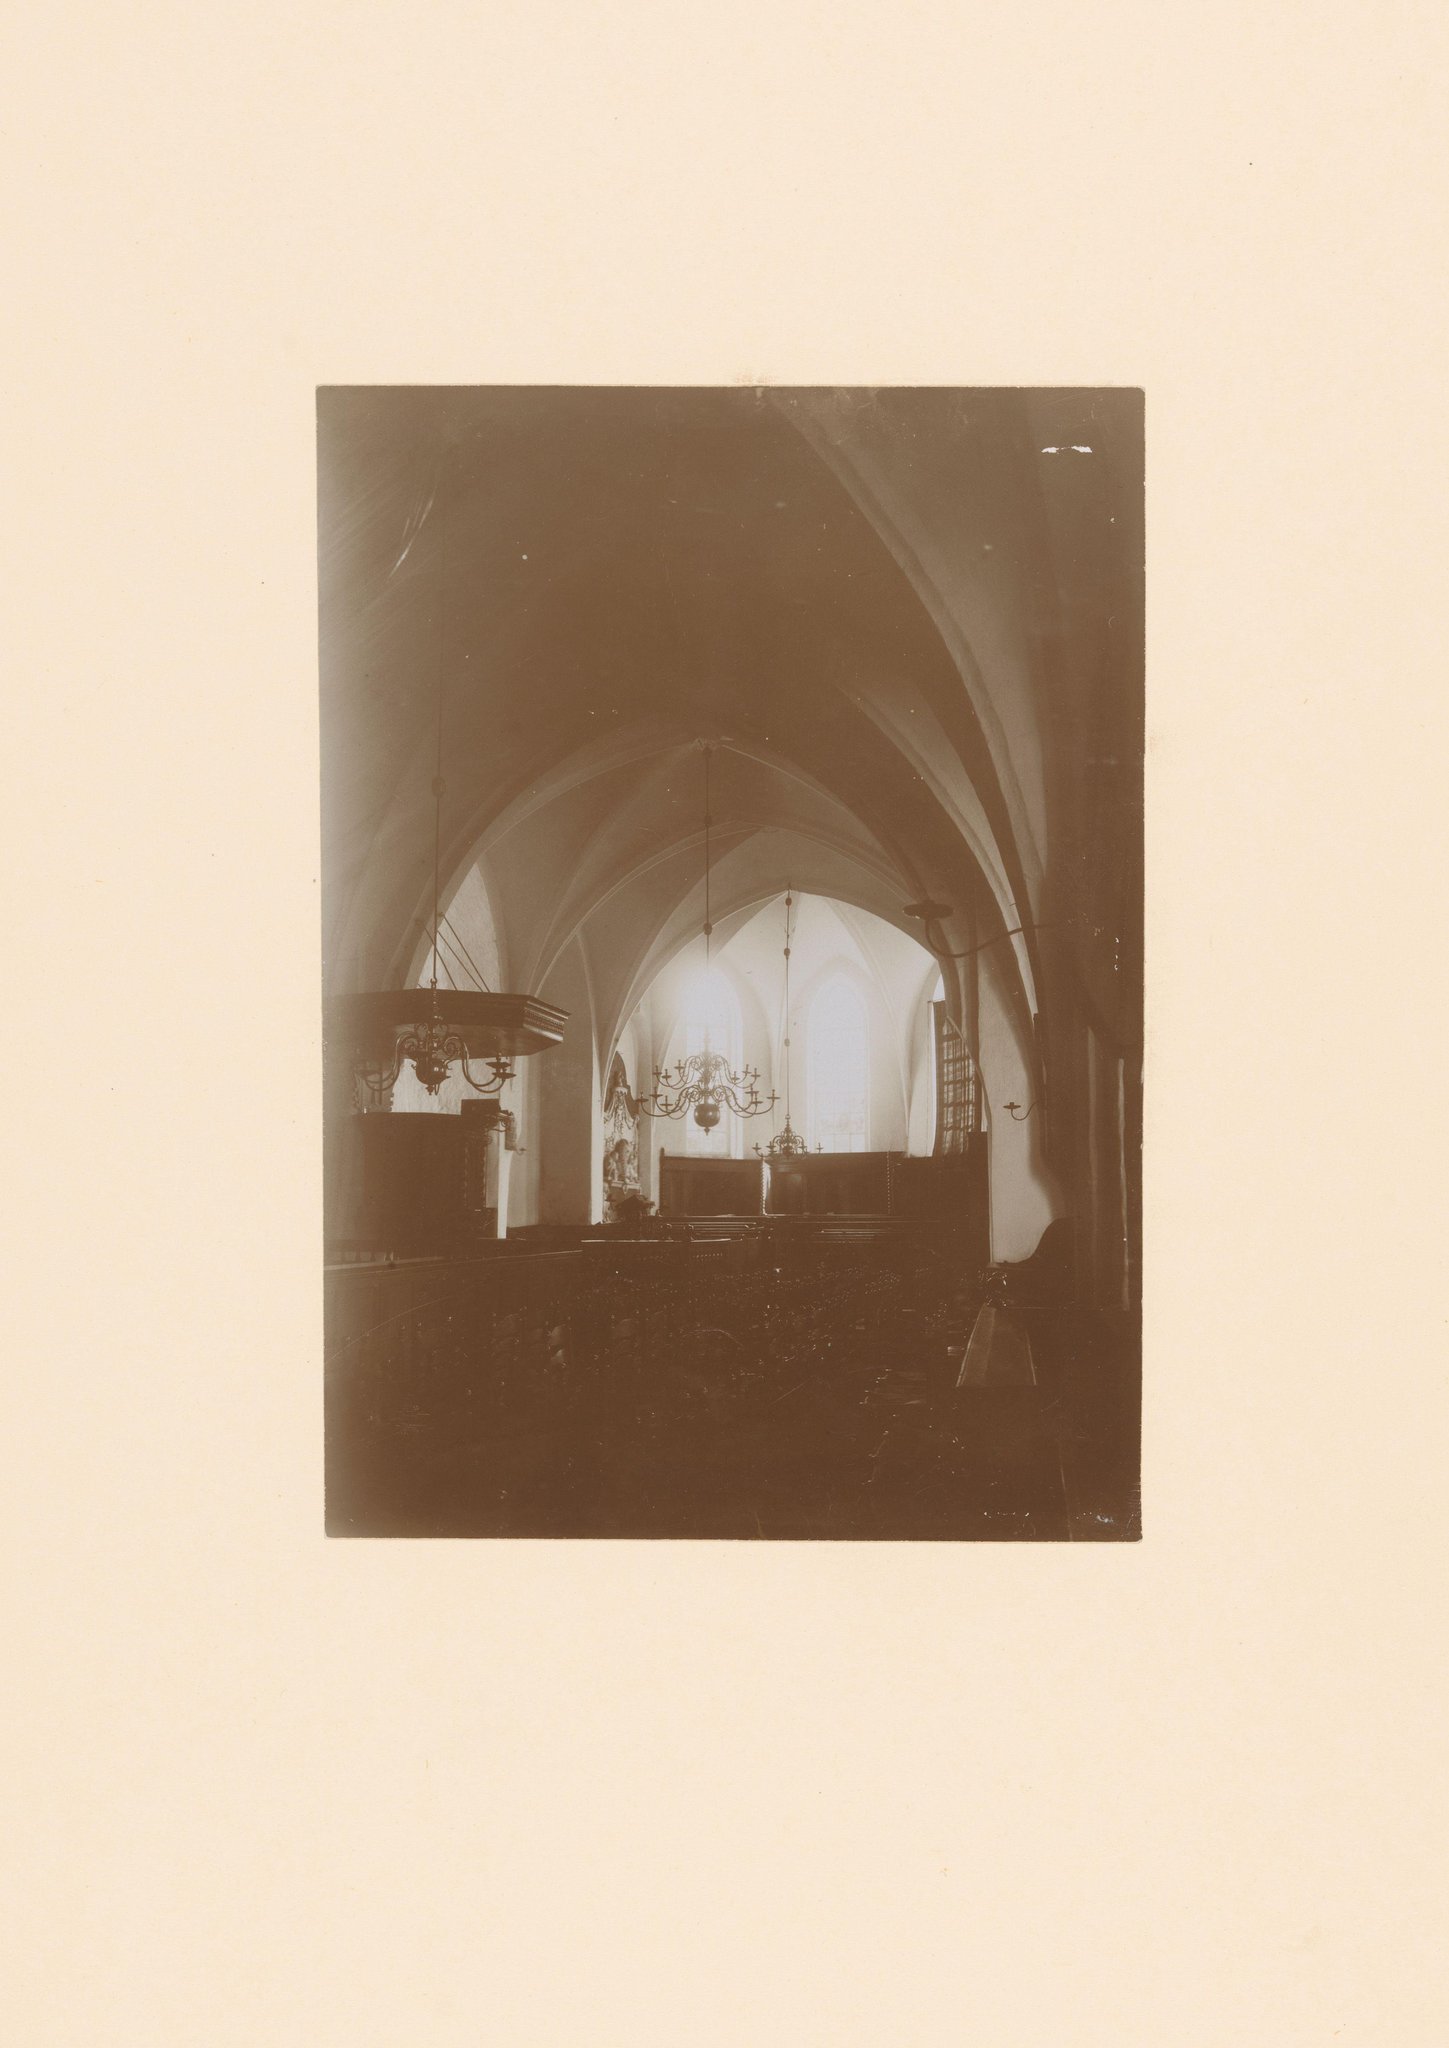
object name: photograph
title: Interieur van de Nicolaaskerk te Wijhe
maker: anoniem (monumentenzorg)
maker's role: fotograaf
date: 1911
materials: cardboard, photographic support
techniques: collodion silver print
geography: st nicholas church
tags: interior of church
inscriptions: annotation: ‘Ned. Herv. kerk te Wijhe aug 1911’, annotation: ‘Wijhe’